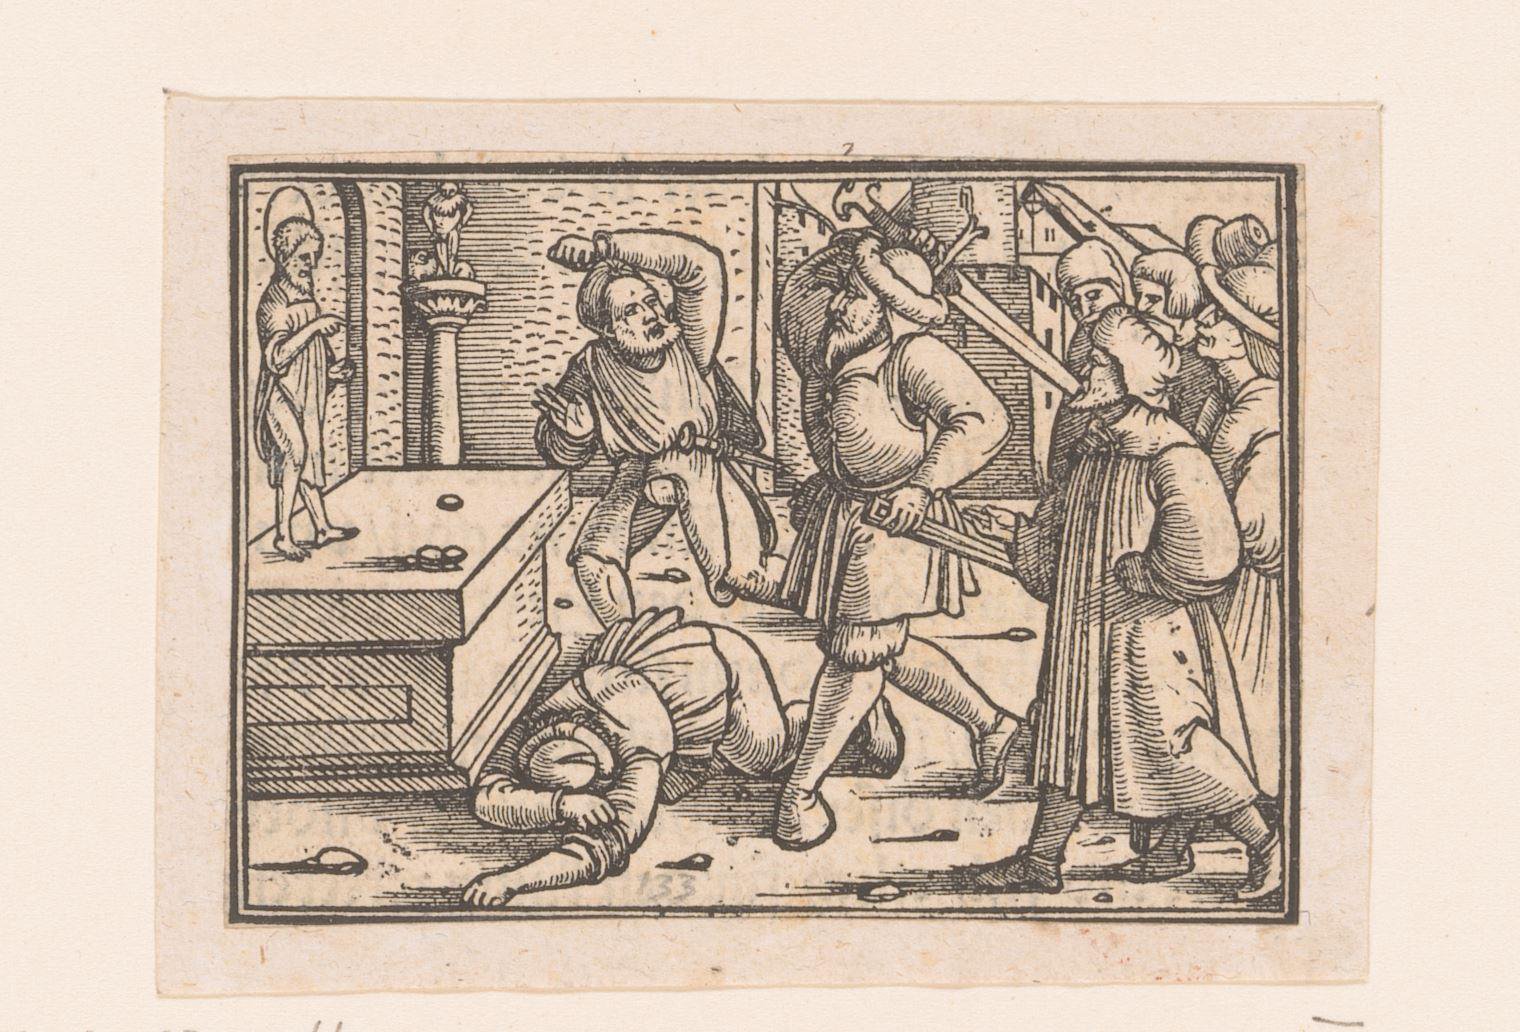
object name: print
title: Twee mannen die afgodsbeelden aanbidden worden gedood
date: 1552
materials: paper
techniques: woodcut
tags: baasha kills all the members of jeroboam's family, thus fulfilling the prophecy of ahiljah, and leads israel into the worship of idols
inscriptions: collector's mark: Lugt 240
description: Mogelijk een kopie van een prent van Hans Holbein de jongere. Niet uit de Icones historiarum Veteris Testamenti van 1538. Deze kopie mogelijk uit: Biblia sacra iuxta vulgatam. Parijs: Jean Benoît, 1552. Ook aanwezig in de Herzog August Bibliothek: http://diglib.hab.de?grafik=graph-res-d-326-1.